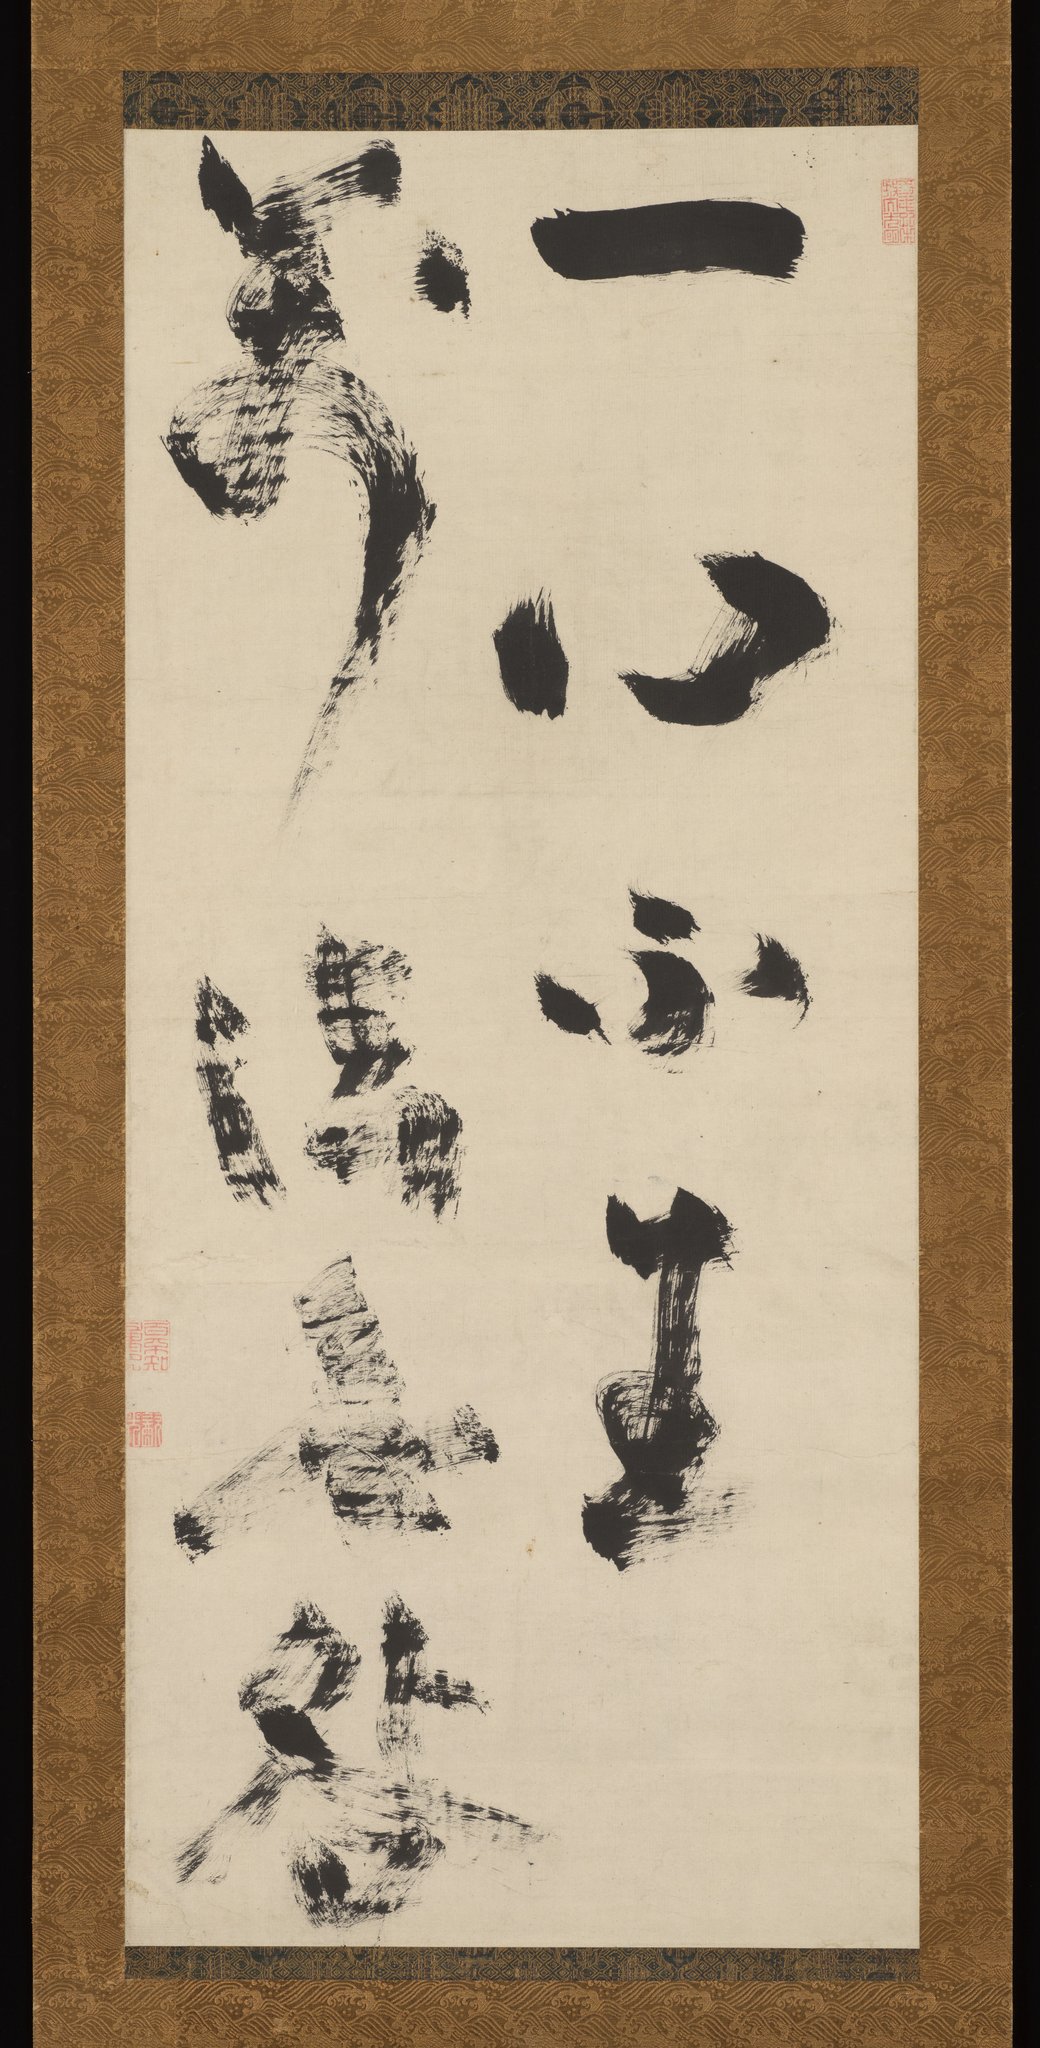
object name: hanging scroll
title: Passage from an Inscription on Trust in the Mind (Xinxinming)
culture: japanese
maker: jiun onkō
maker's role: artist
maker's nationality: japanese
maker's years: 1718-1804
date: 1767-1800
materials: ink, paper